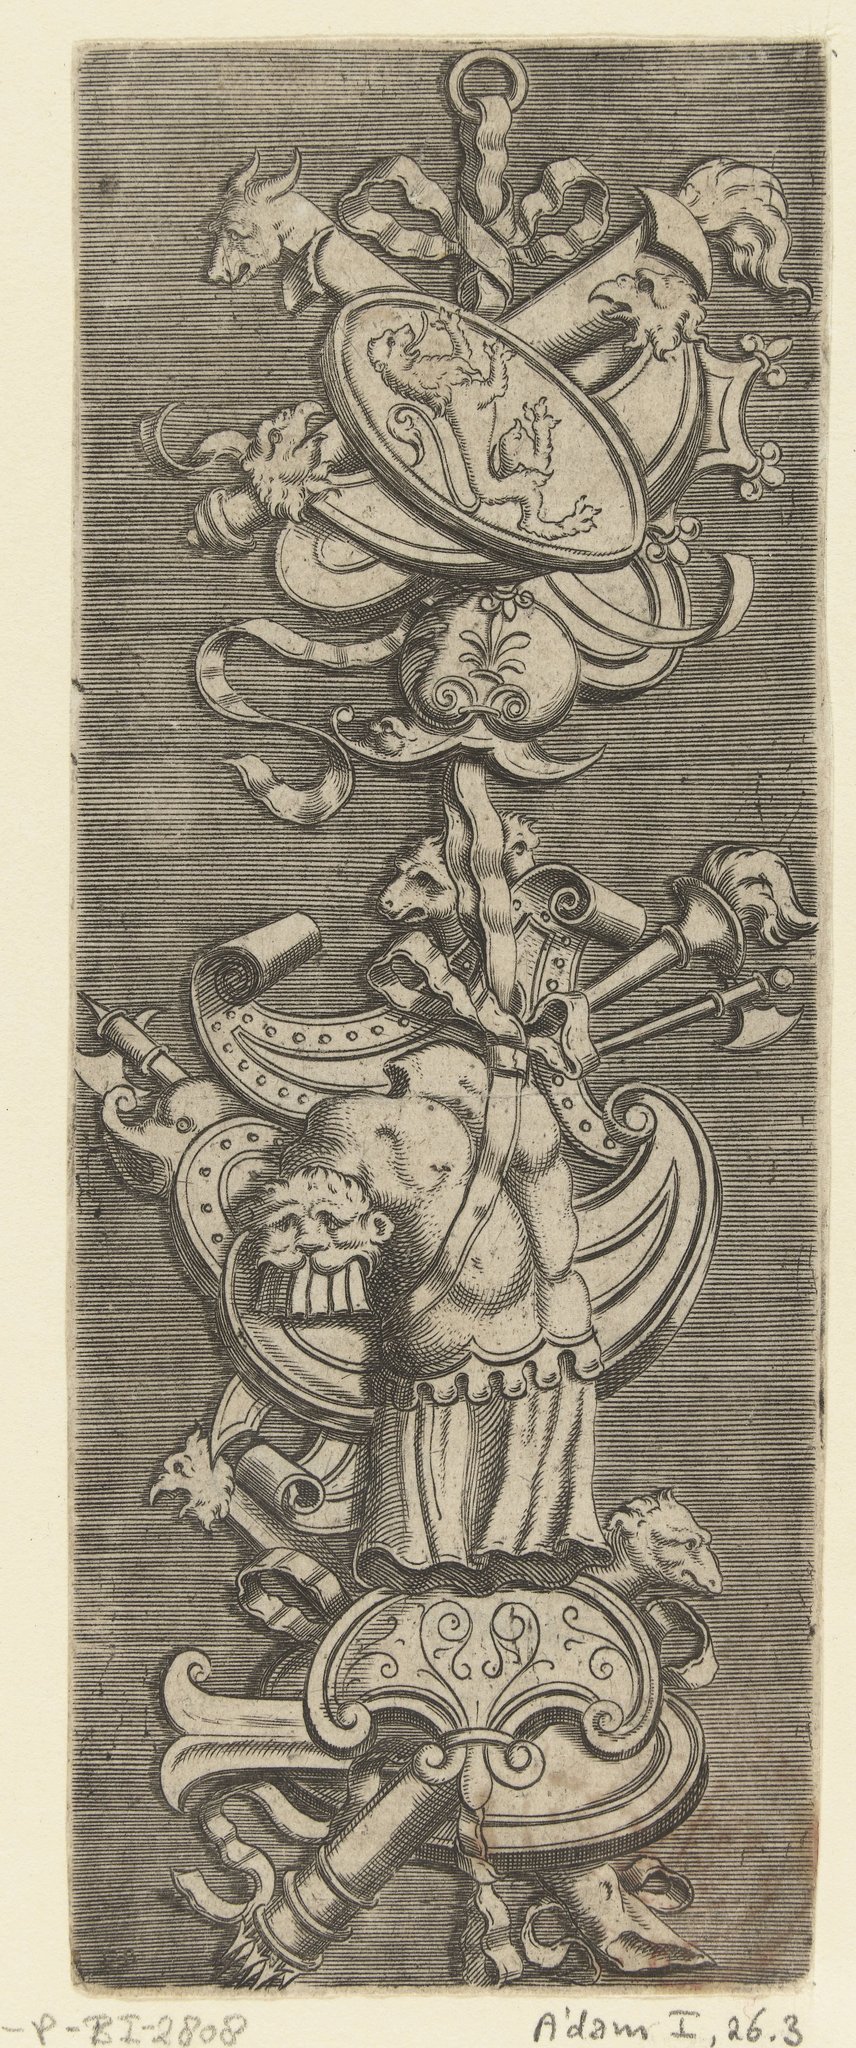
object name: print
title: Vlakdecoraties met wapentrofeeën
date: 1516-1565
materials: paper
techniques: engraving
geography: netherlands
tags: trophy, i.e.: decorative arrangement of symbolic or typical objects ~ ornament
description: Bovenaan hangen schilden, waarvan één met de voorstelling van een leeuw. Daaronder hangt een wapenrusting. Hoort bij 5 bladen uit een serie van 7.